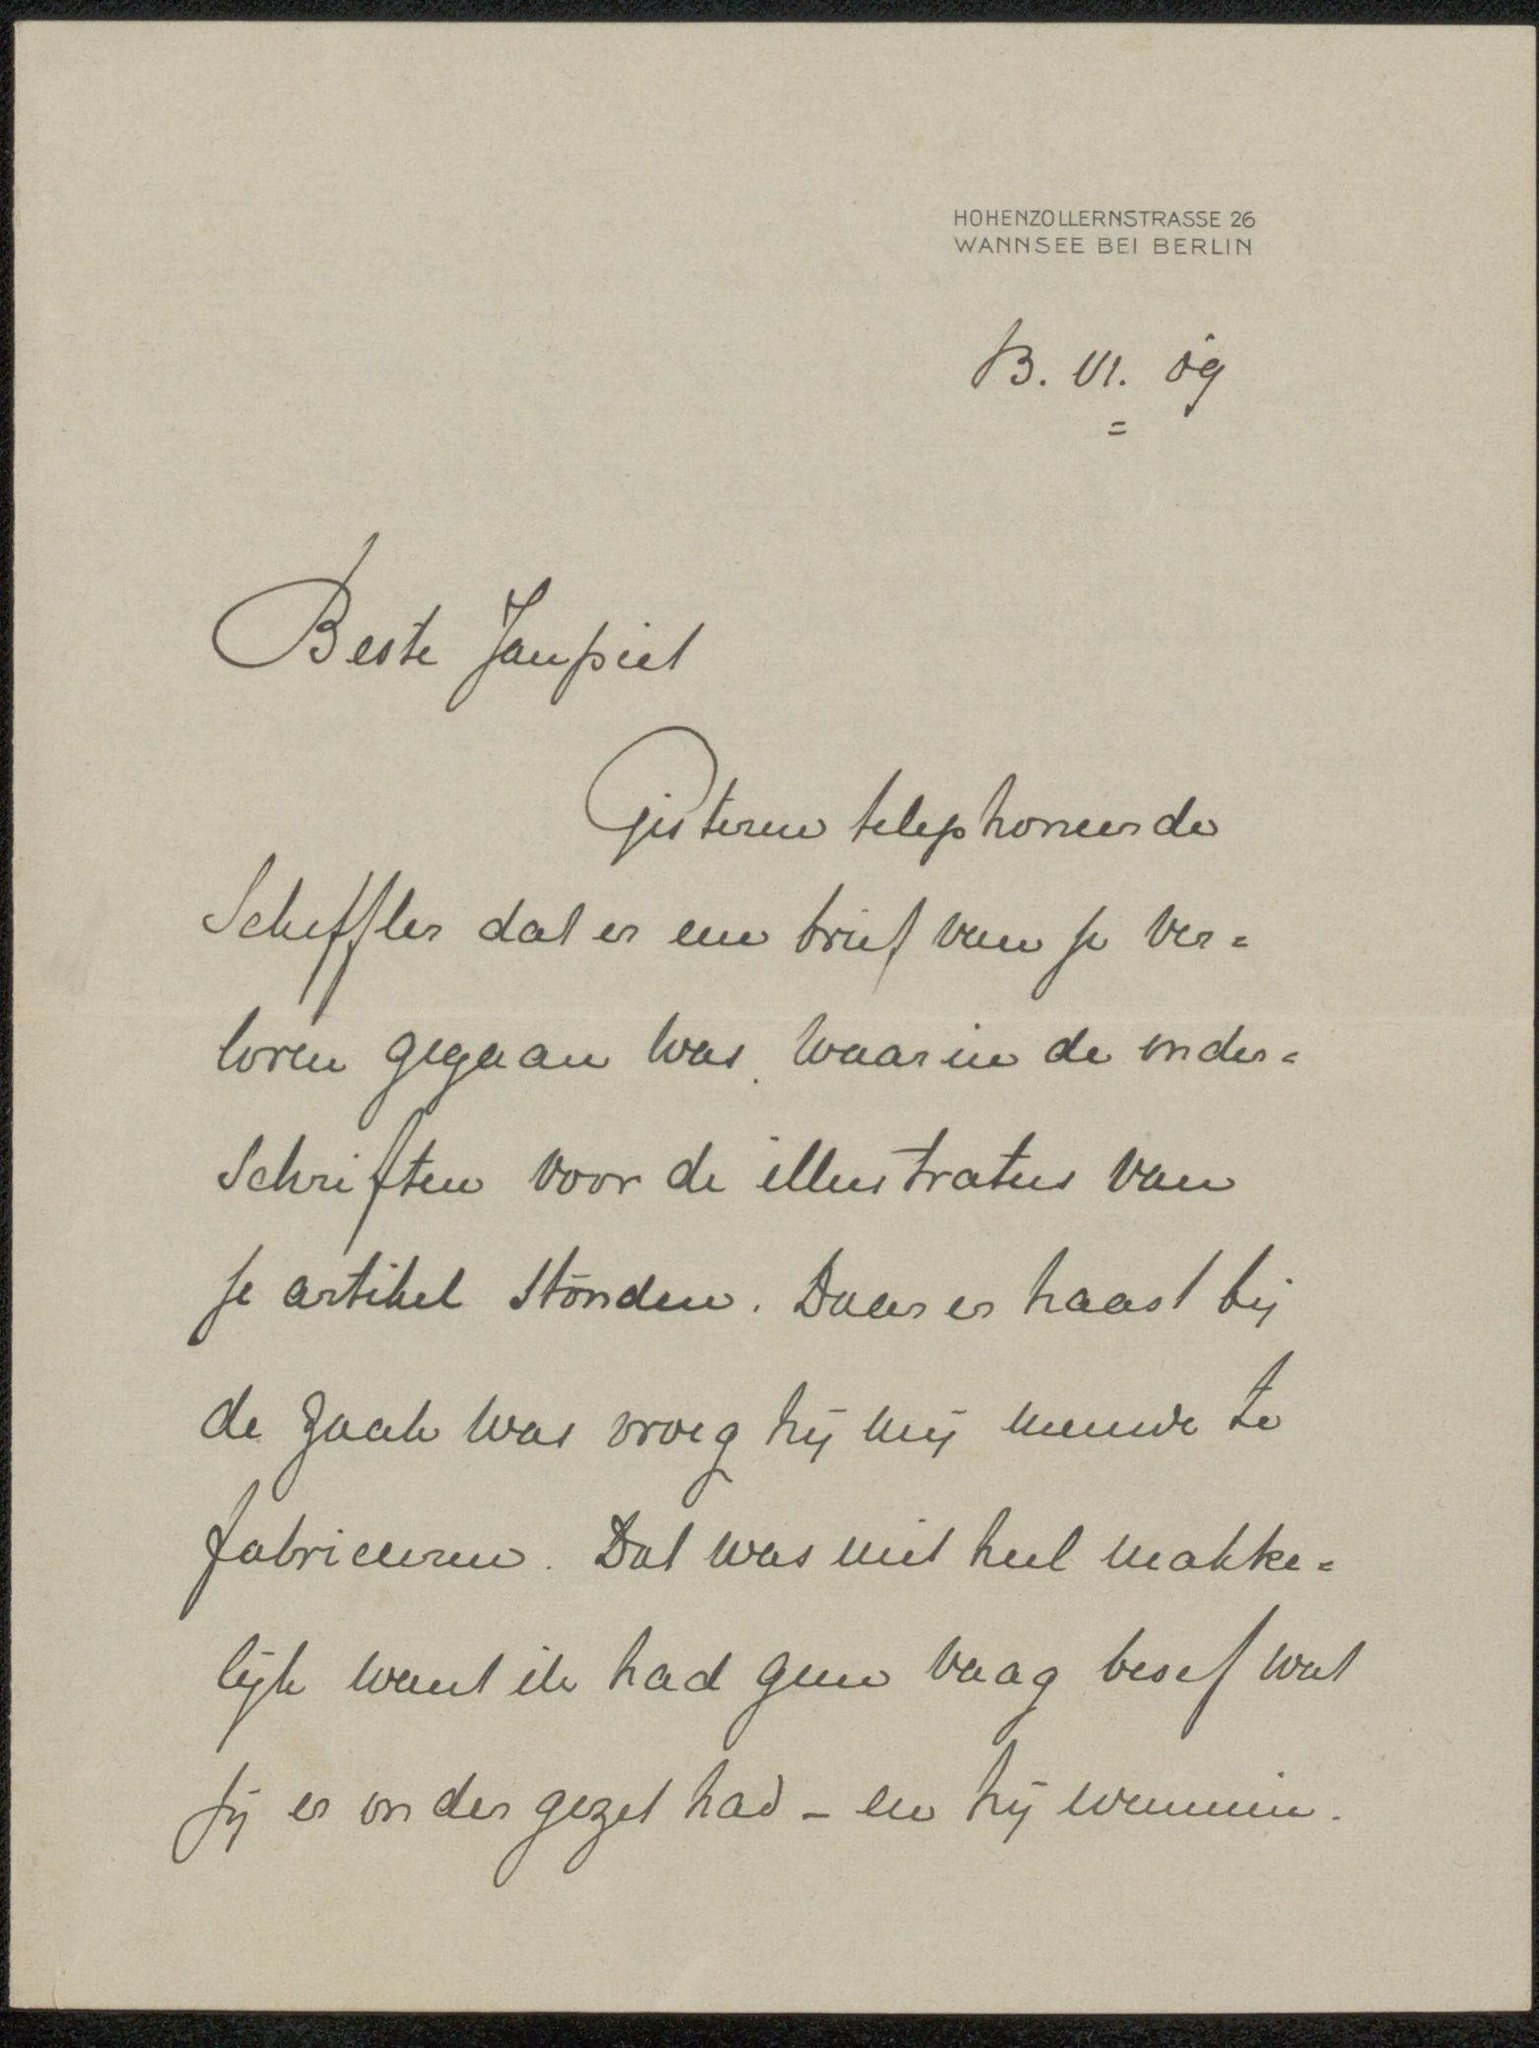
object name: letter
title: Brief aan Jan Veth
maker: andré jolles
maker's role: journalist, kunsthistoricus, letterkundige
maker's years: 1874-1946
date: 1909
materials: ink, paper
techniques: pen, printing, writing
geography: wannsee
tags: theodor graf, amsterdam, painter, draughtsman, designer, jan veth, middelburg, politician, pieter lodewijk tak, liège, johannes de koo, printed matter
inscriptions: collector's mark: ‘RPK’